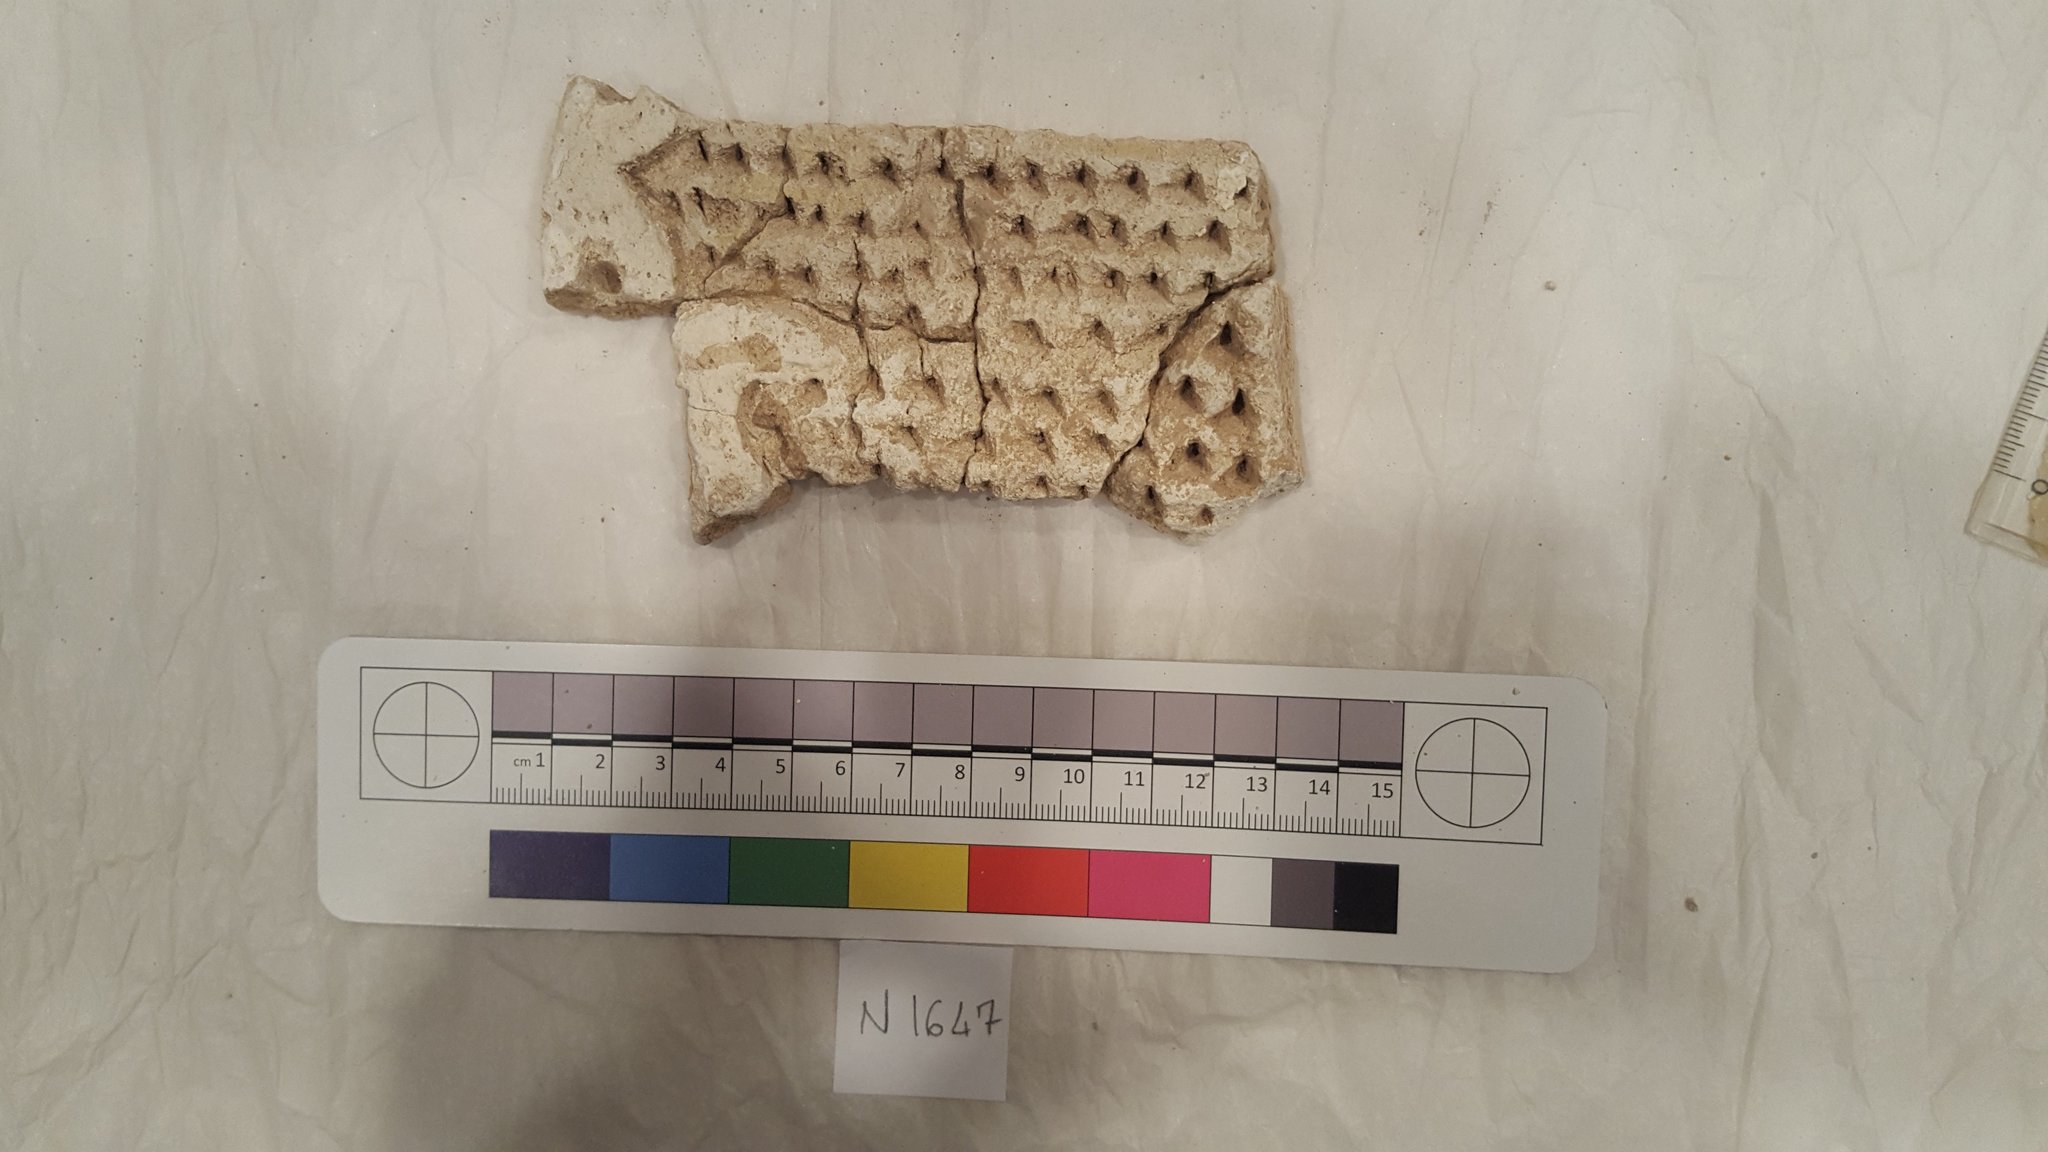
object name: fragment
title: Stucco Fragment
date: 701-1200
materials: plaster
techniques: carving, painting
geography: iran